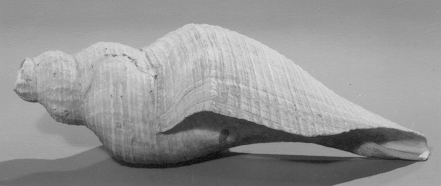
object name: hai lo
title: Hai-Lo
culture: chinese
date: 1801-1900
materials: shell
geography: china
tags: shells